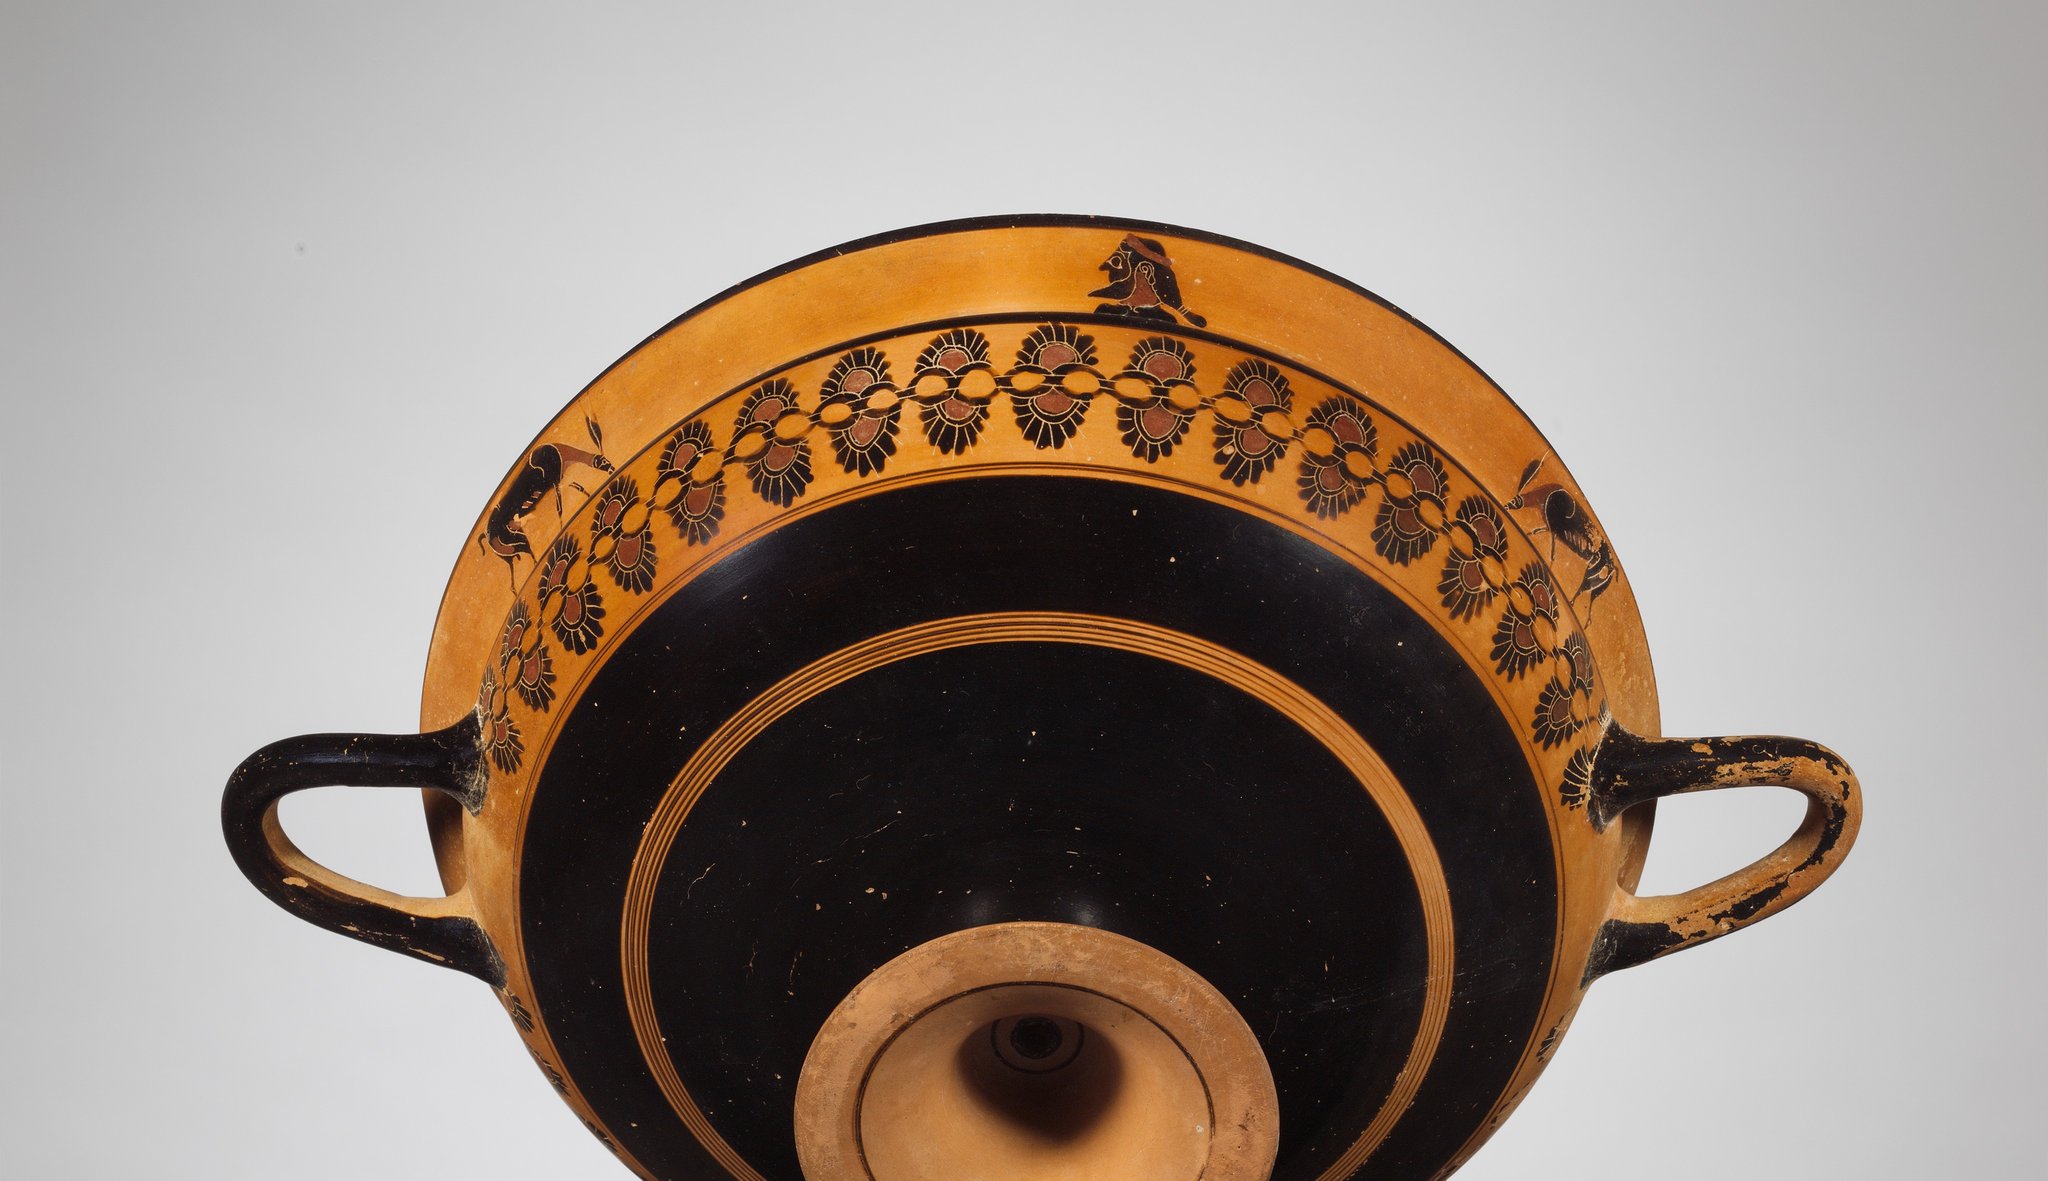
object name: kylix, siana cup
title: Terracotta kylix: Siana cup (drinking cup)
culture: greek, attic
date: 560 BCE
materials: terracotta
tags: roosters,deer